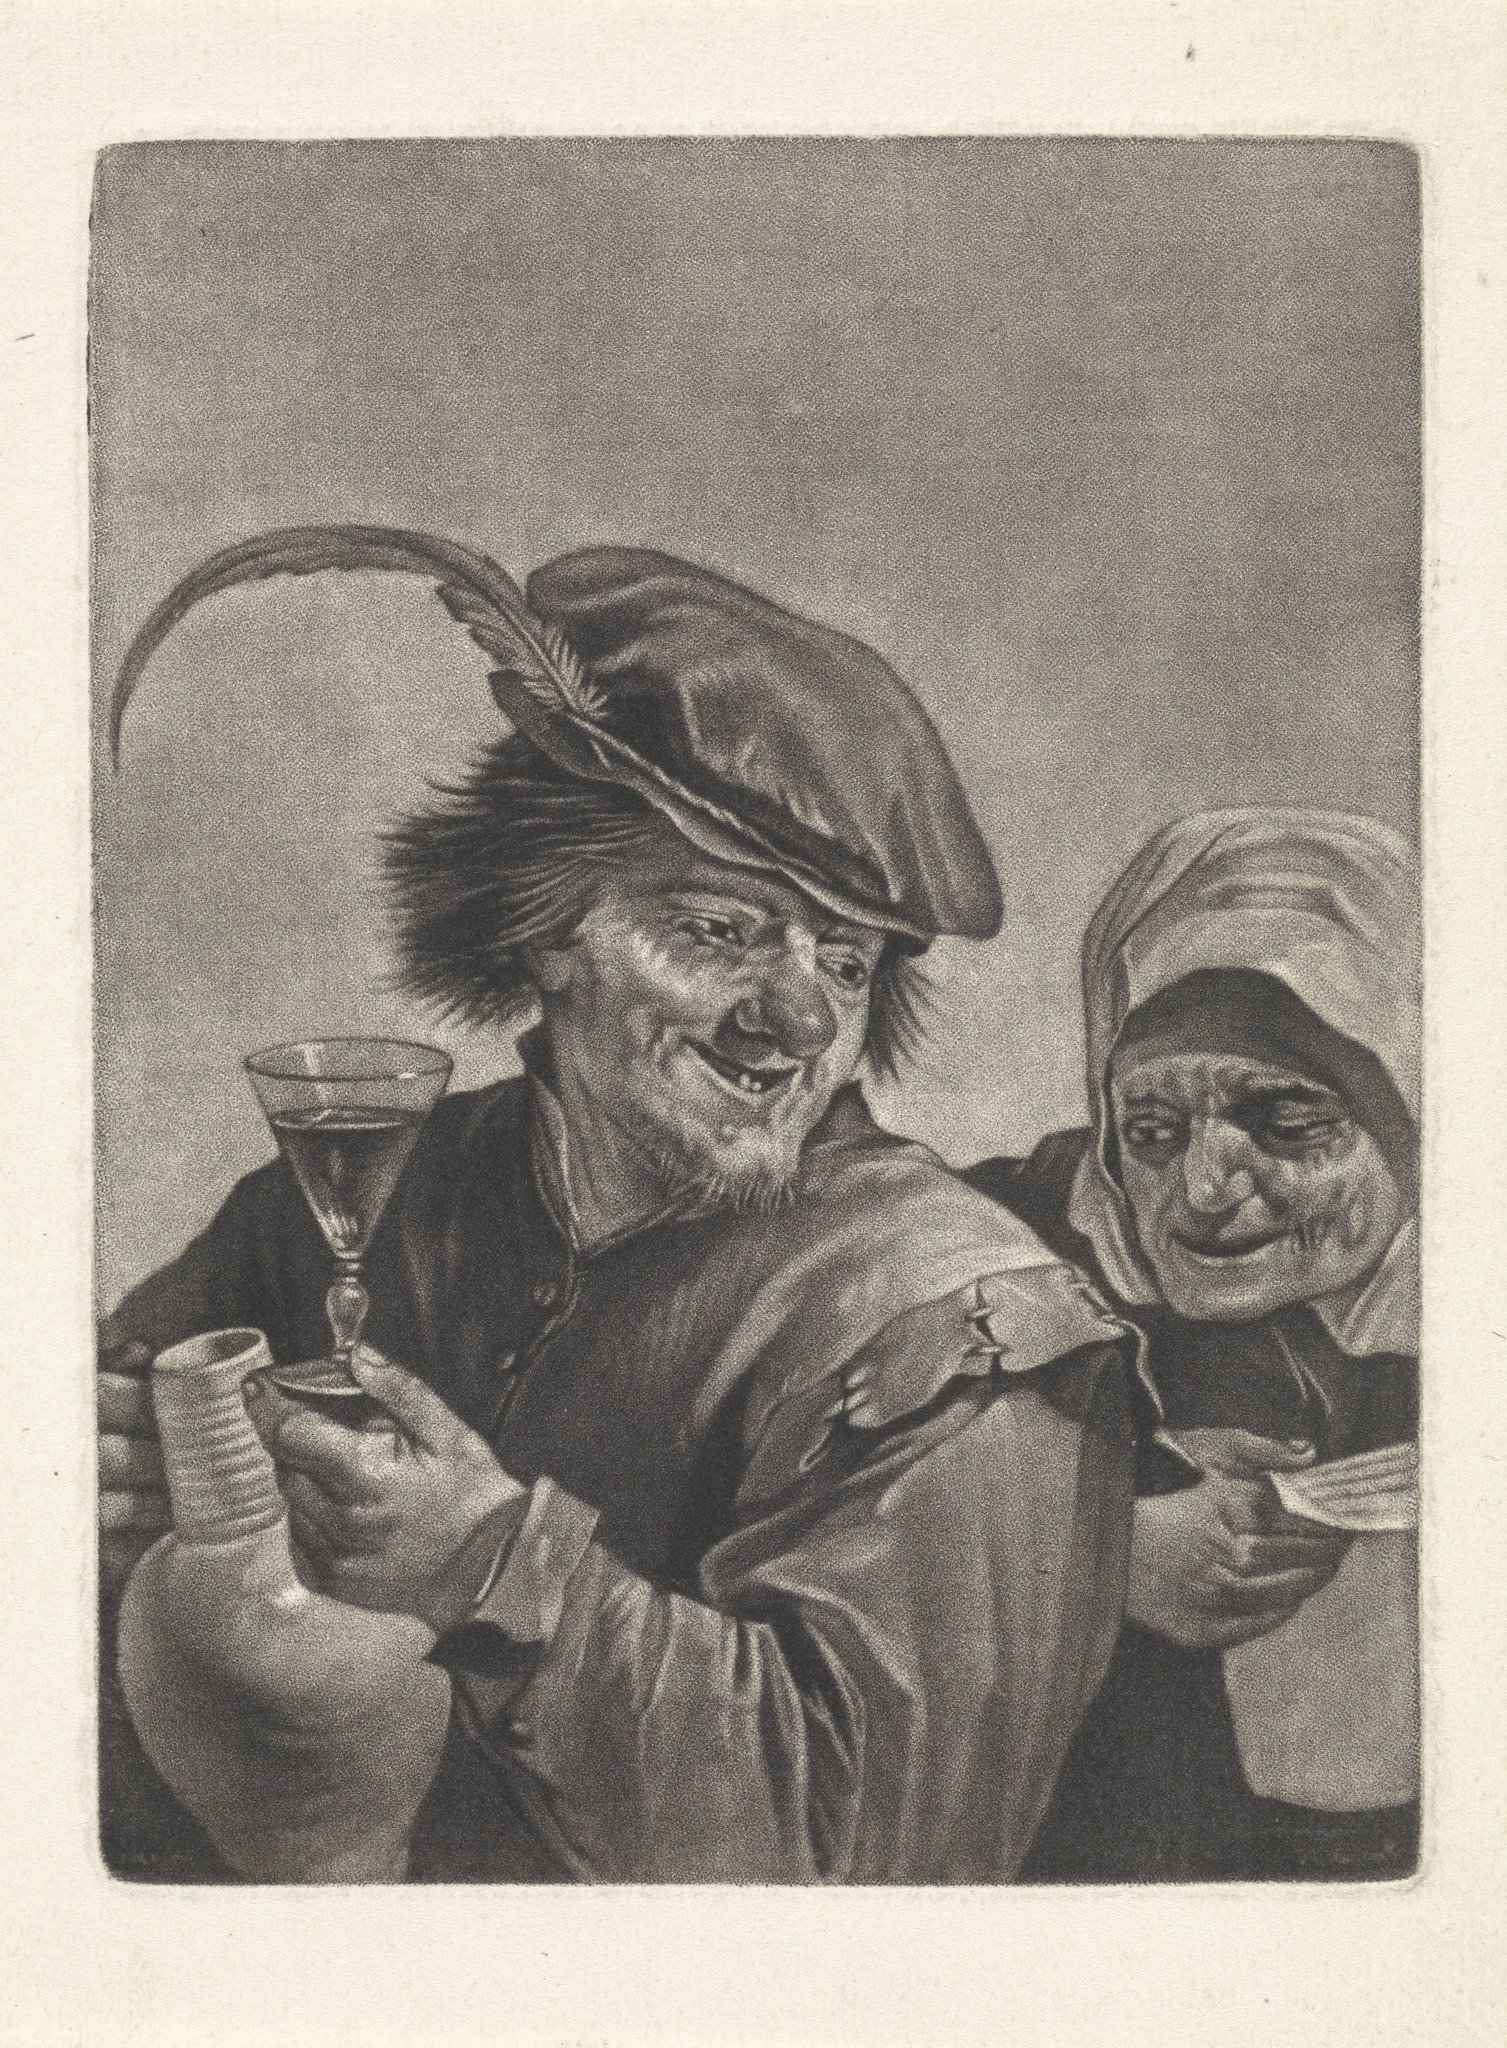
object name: print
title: Man met kan en wijnglas (variant B)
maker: jan van der bruggen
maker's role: draughtsman, print maker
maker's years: 1649-1709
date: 1659-1740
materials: paper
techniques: mezzotint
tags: jar, jug (used as drinking-vessel), wine ~ alcoholic drinks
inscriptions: collector's mark: Lugt 2228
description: Een man houdt een kan en een wijnglas in de handen. Achter hem een oude vrouw met een papier in de hand.